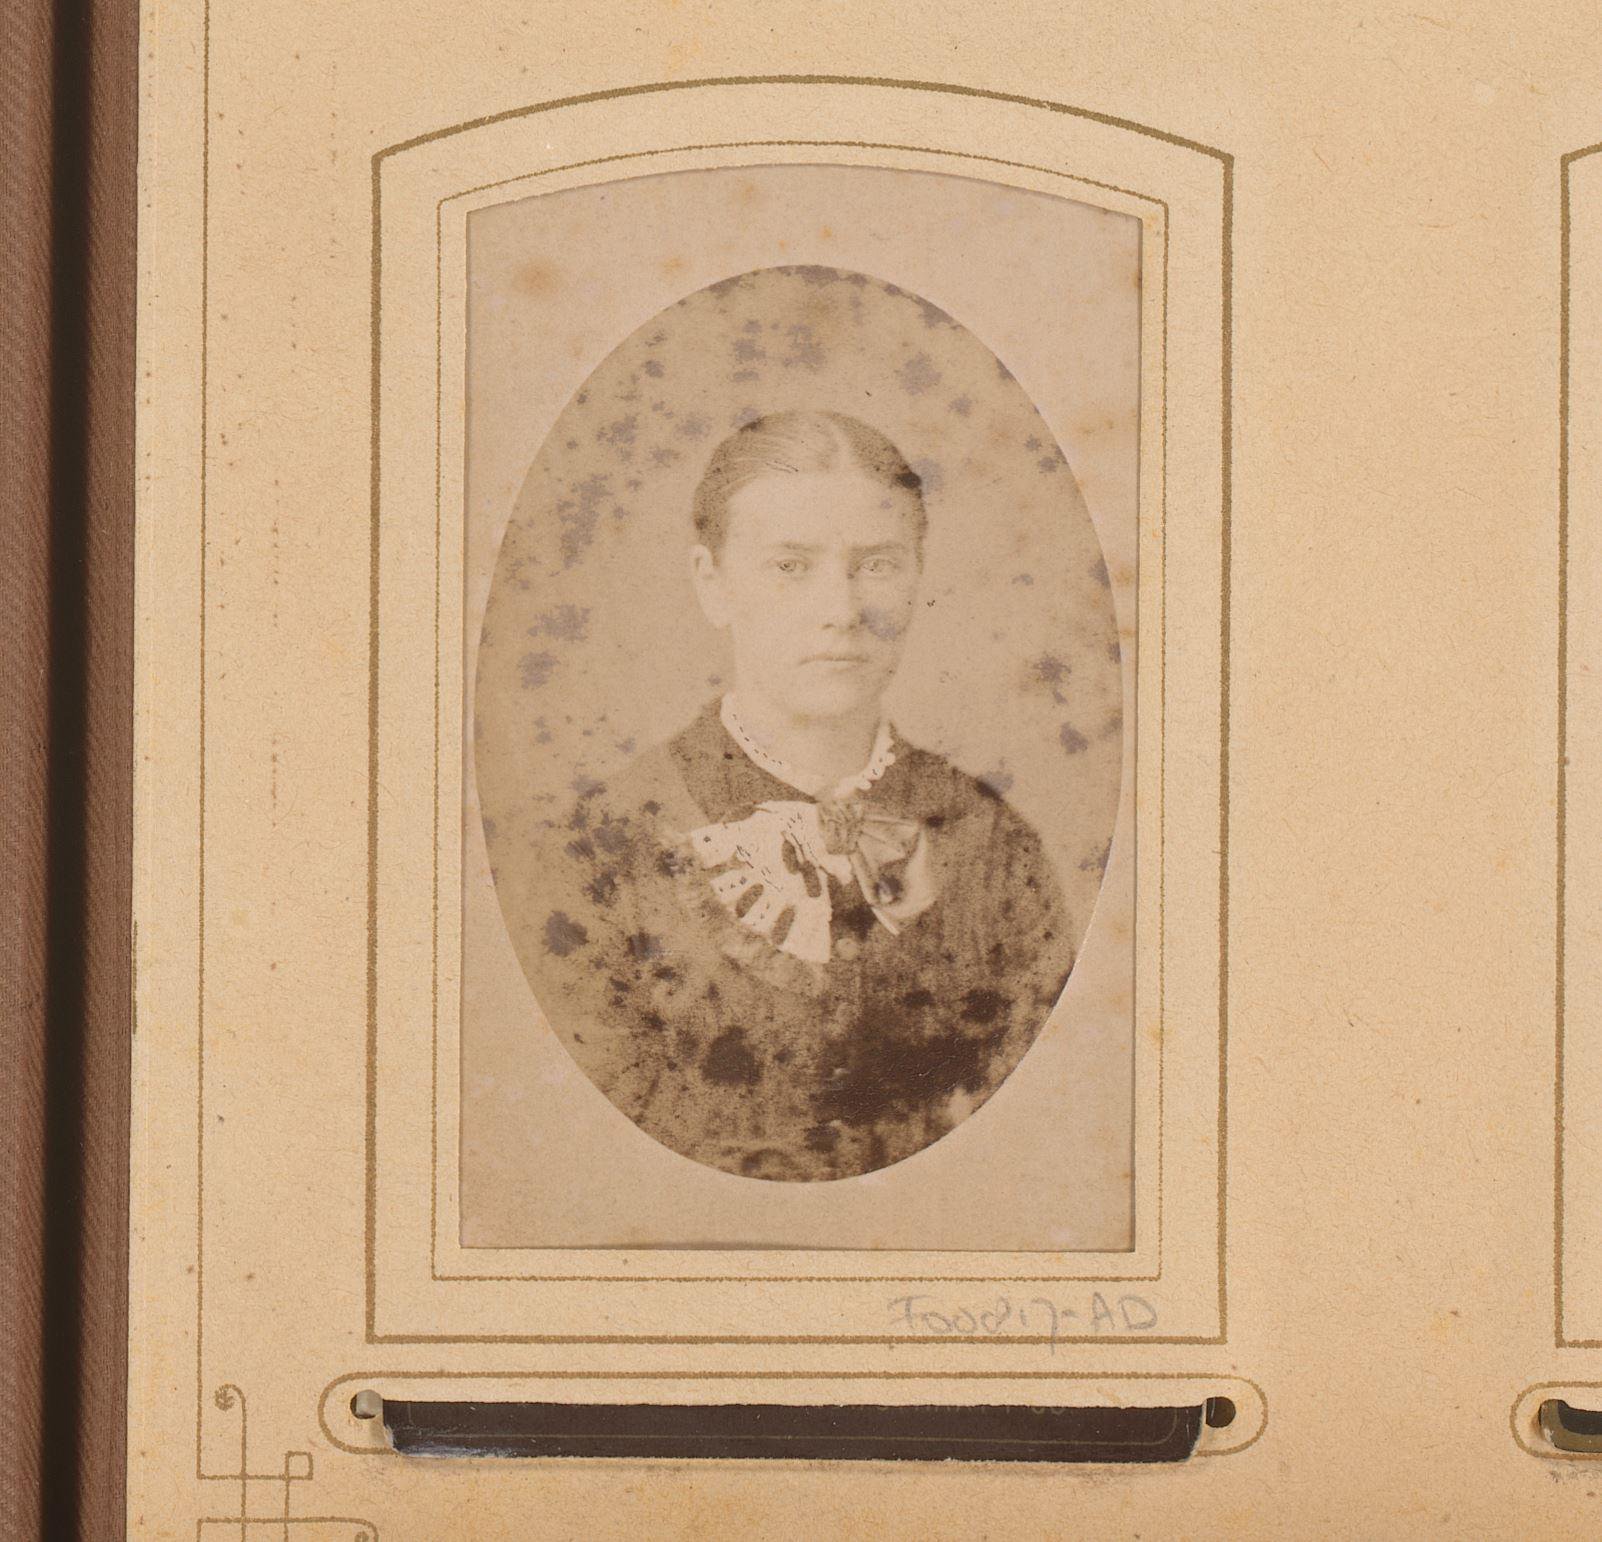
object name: album leaf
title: Portret van een jonge vrouw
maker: mozes cohen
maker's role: fotograaf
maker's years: 1821-1899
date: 1860-1899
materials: cardboard, photographic support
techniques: albumen print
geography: zwolle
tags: adolescent, young woman, maiden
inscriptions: inscription: ‘Cohen's Photografische Inrigting/ Nieuwstraat/ Zwolle’, inscription: ‘Cohen's Photografische inrichting/ Zwolle/ Nieuwsraat F60’